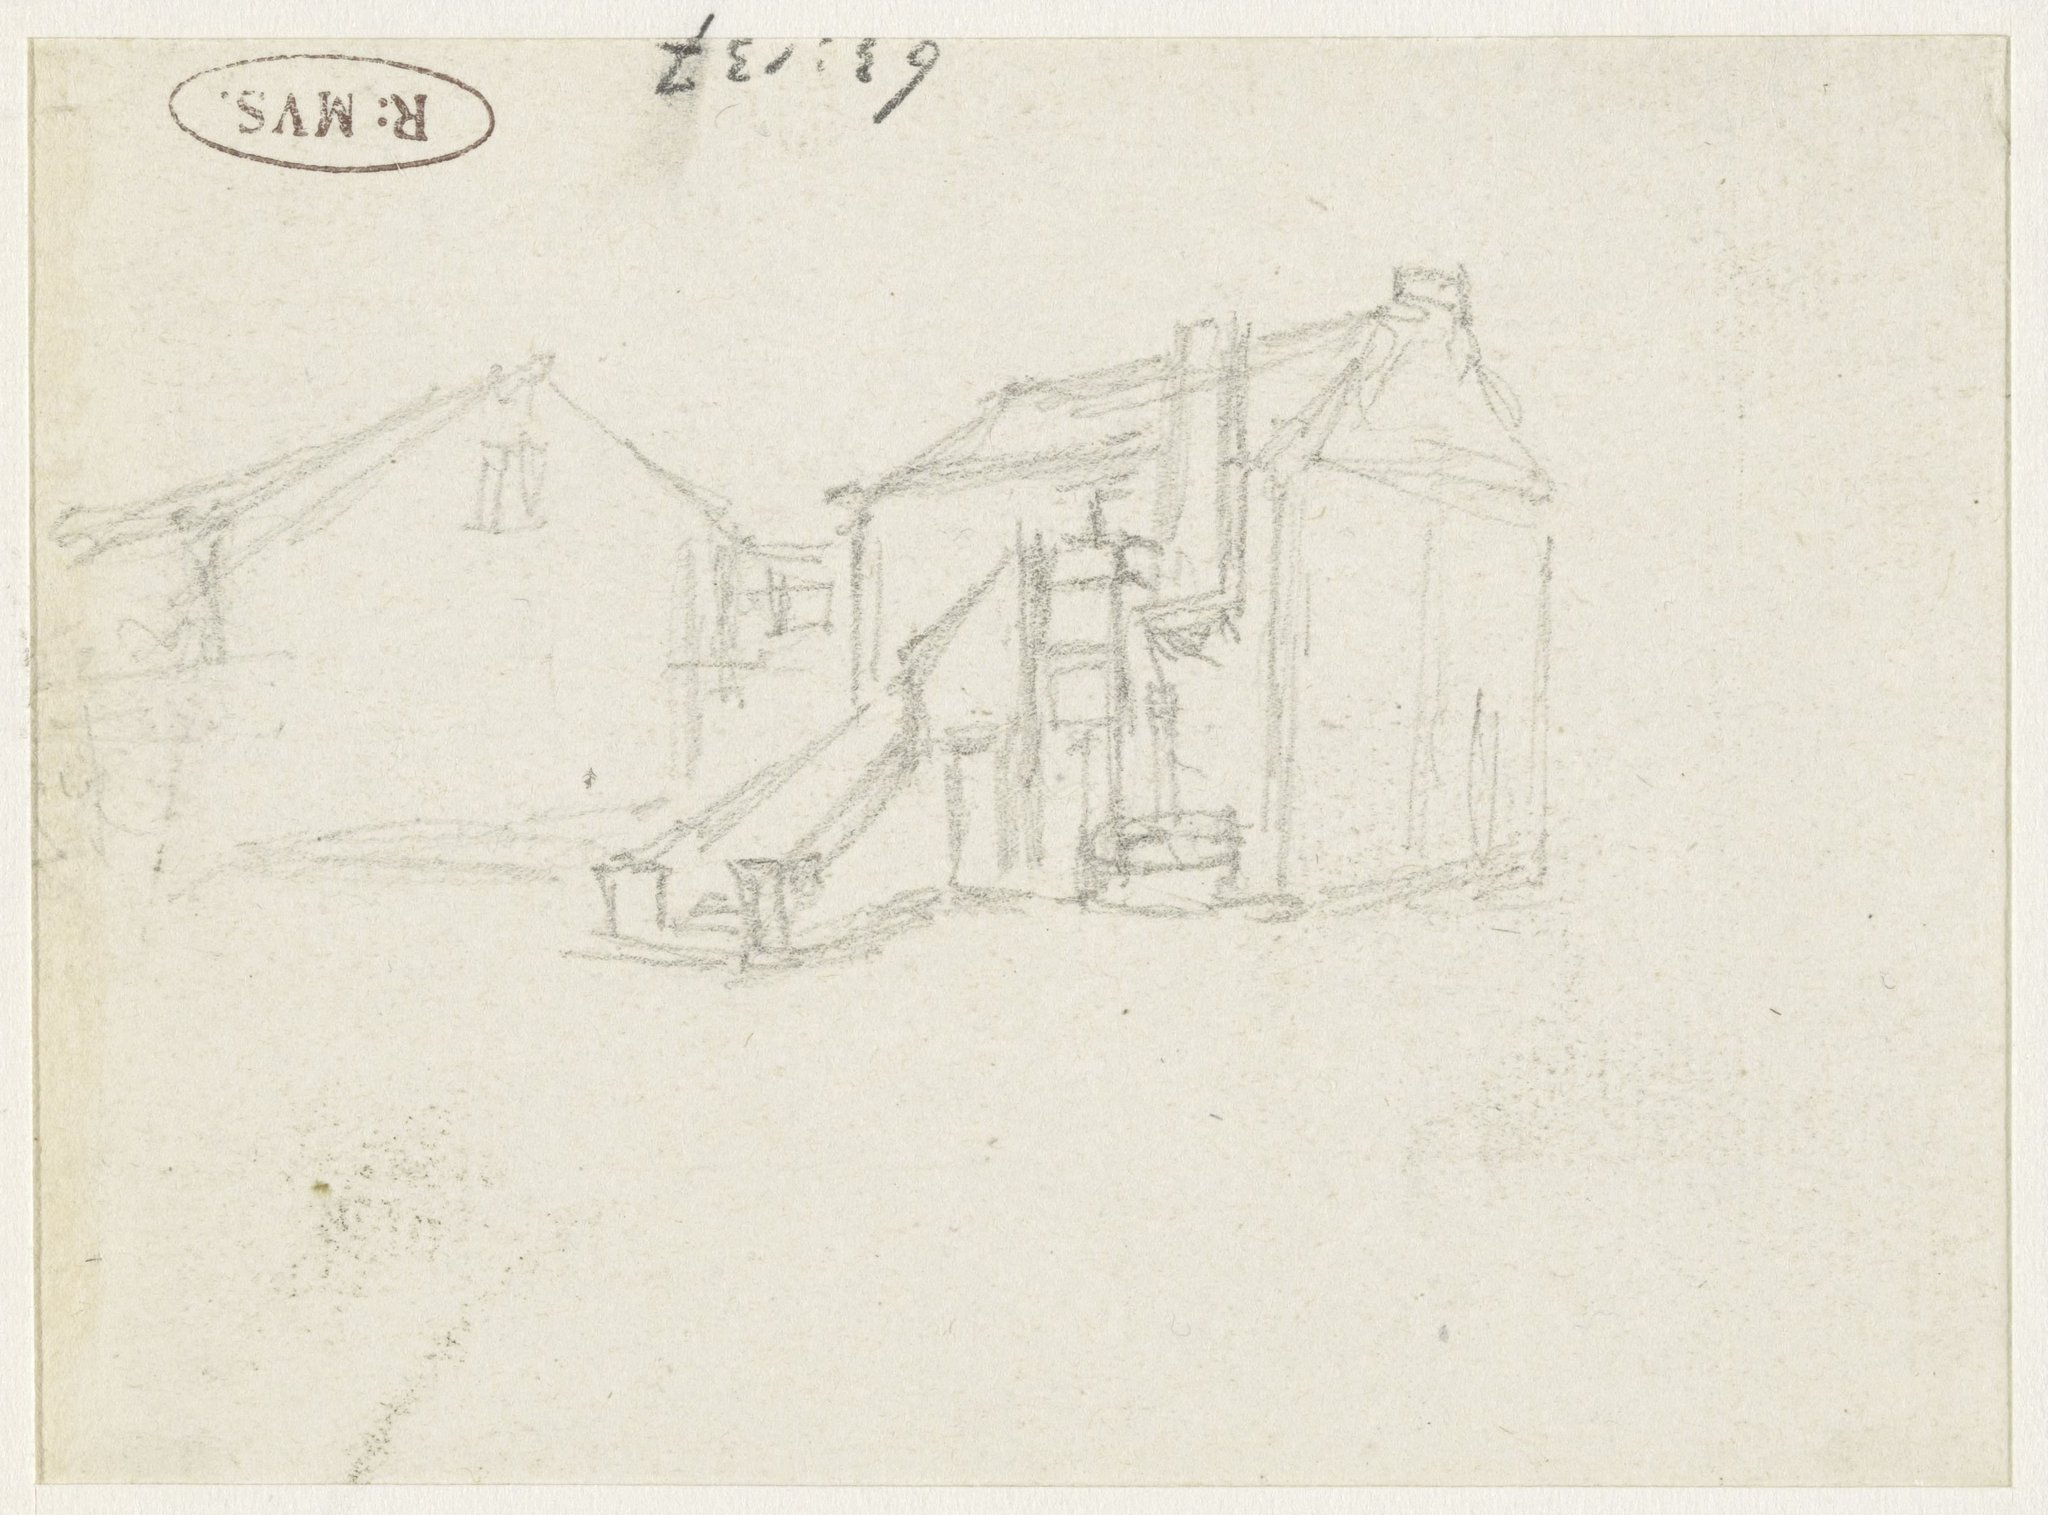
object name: drawing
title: Boerderij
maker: georges michel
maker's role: draughtsman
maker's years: 1763-1843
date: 1773-1843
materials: paper, pencil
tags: farm or solitary house in landscape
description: Een van 120 tekeningen, afkomstig uit een 19e eeuws album met tekeningen van Georges Michel.